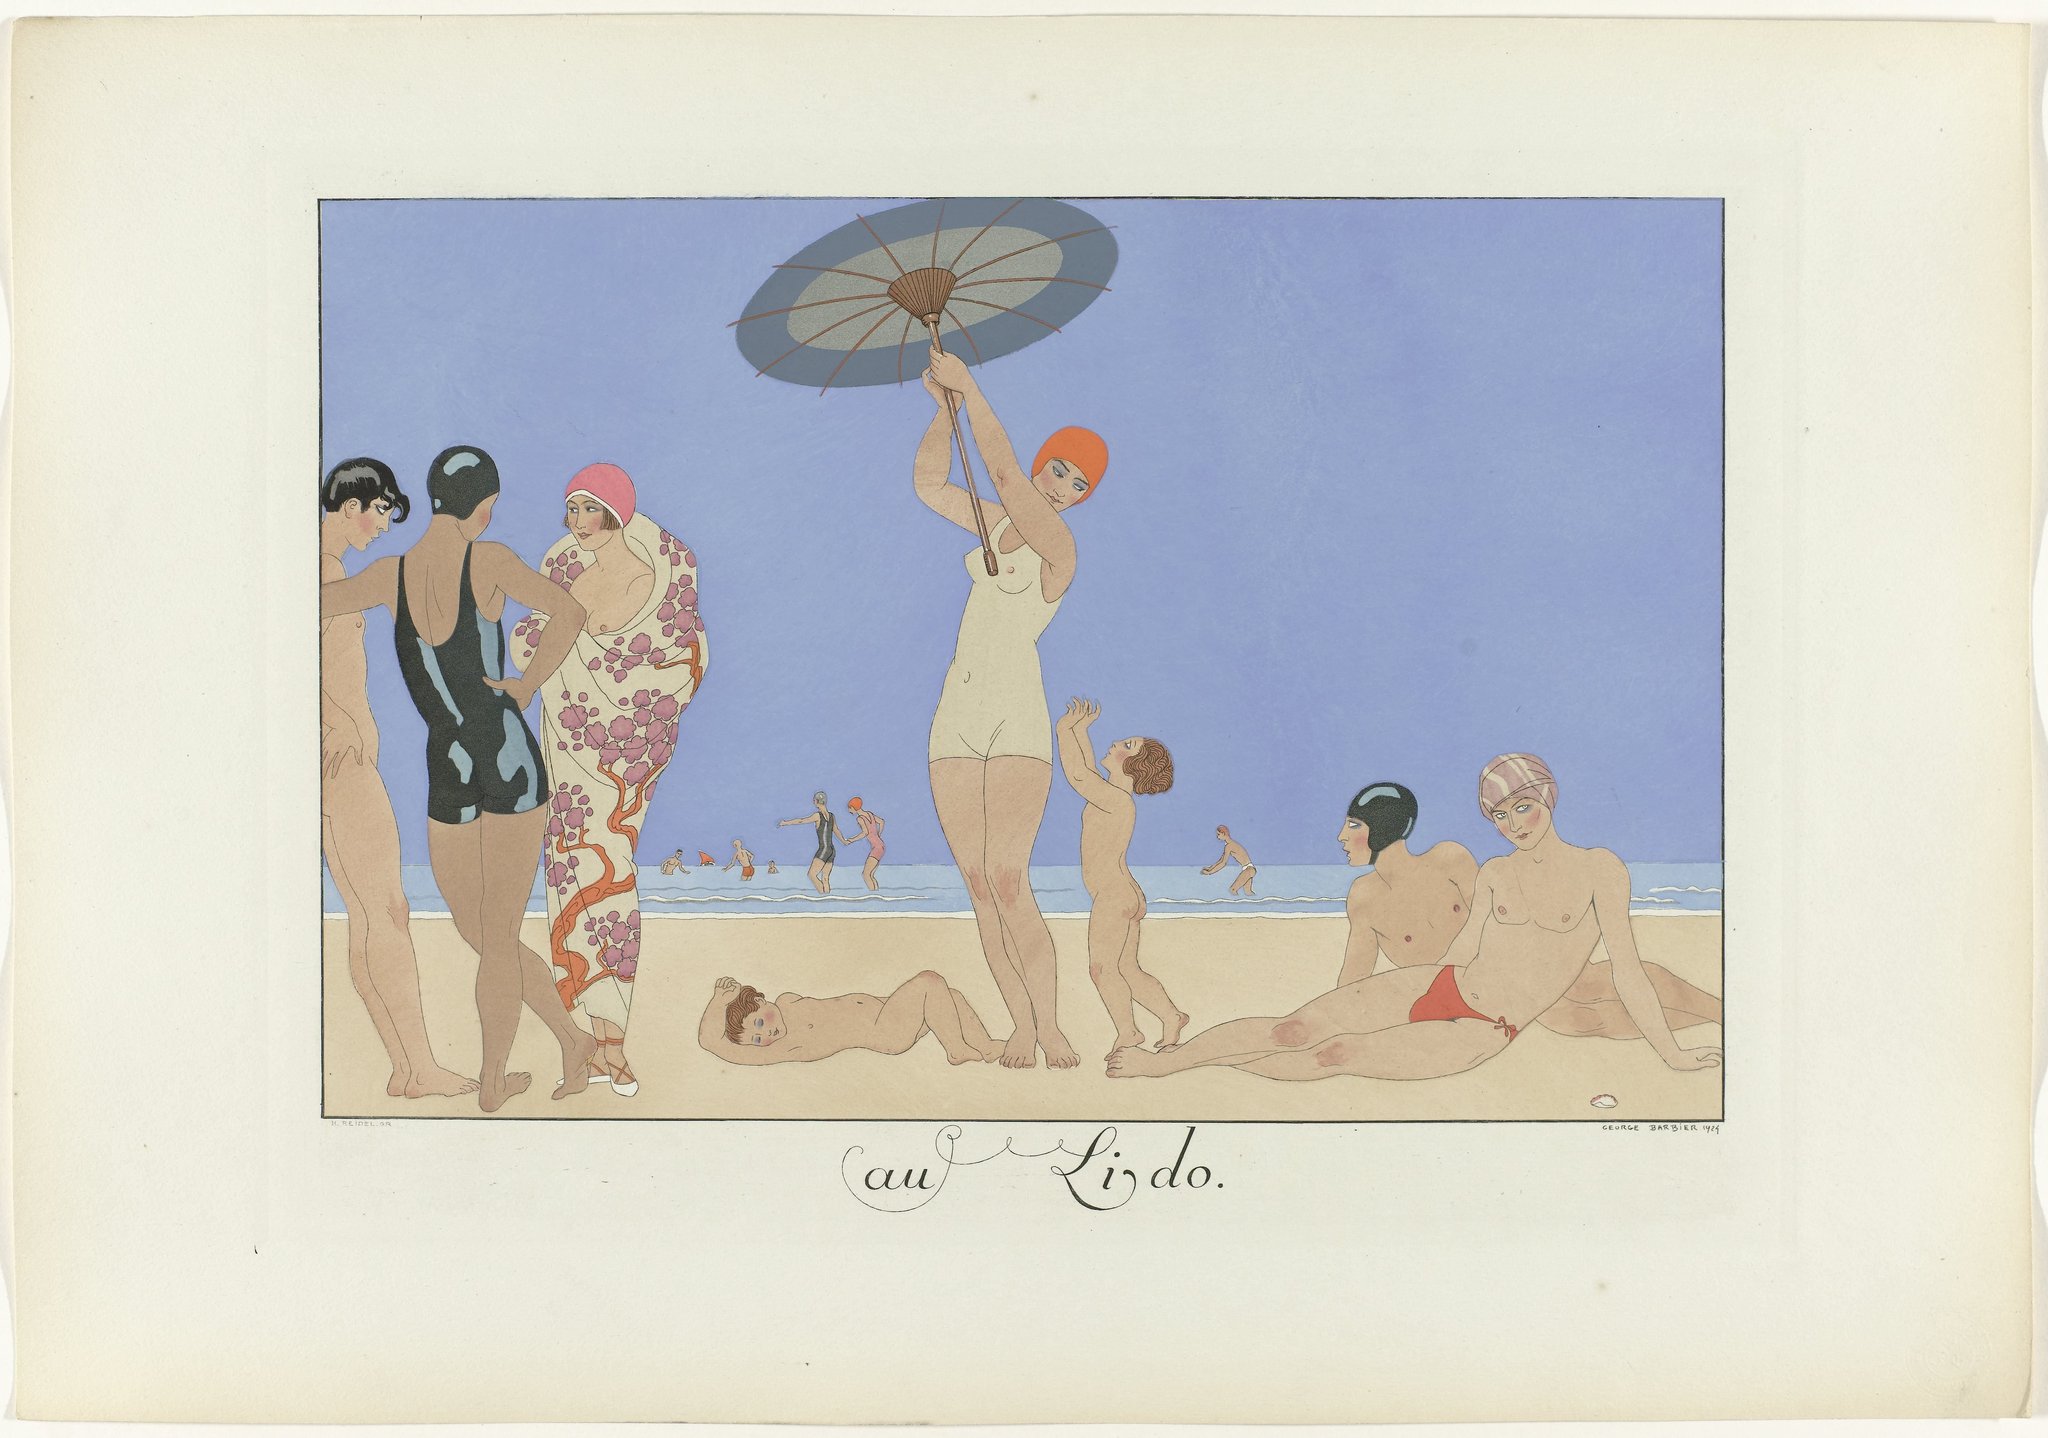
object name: fashion print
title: Le Bonheur du Jour ou Les Graces à la Mode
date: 1924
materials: paper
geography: paris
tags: sunbathing (on the beach), fashion plates, parasol, sunshade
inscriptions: date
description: Uit serie Le Bonheur du Jour ou Les Graces à la Mode.